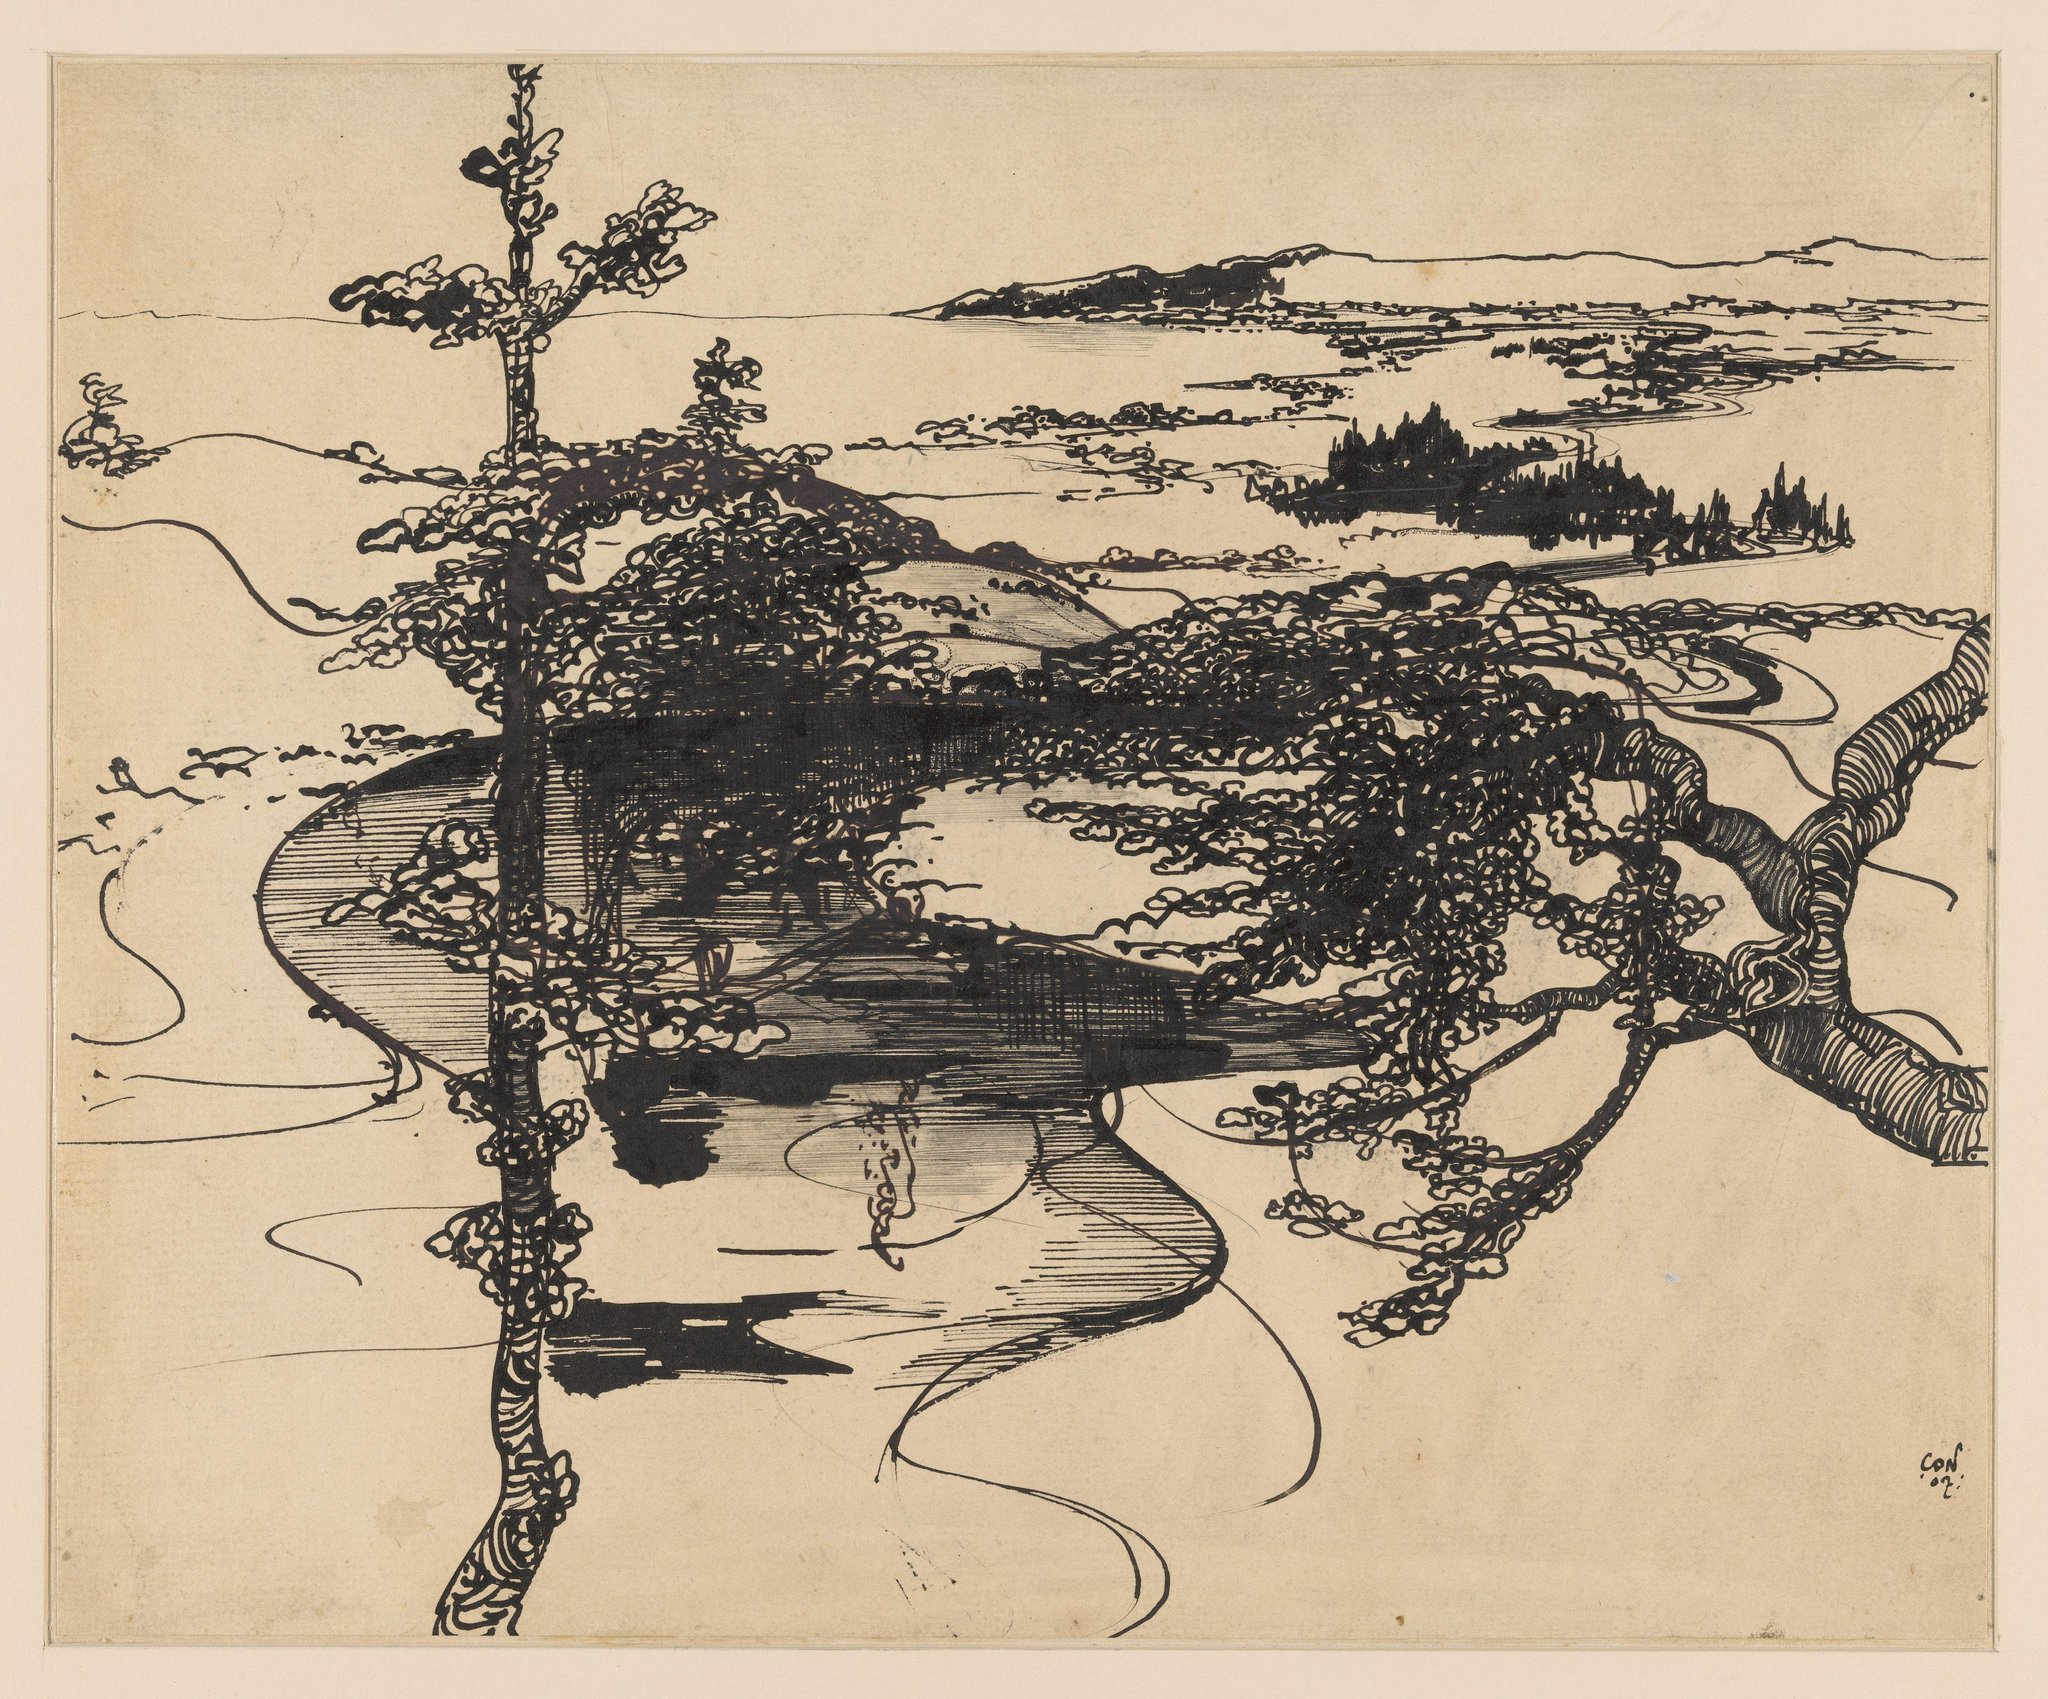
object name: drawing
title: Fantasielandschap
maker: karel de nerée tot babberich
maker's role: draughtsman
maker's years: 1880-1909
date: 1907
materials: ink, paper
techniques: pen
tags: landscapes in the temperate zone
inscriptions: collector's mark: Lugt 2228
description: Op verso een tekening van een naakte vrouw, op de rug gezien.